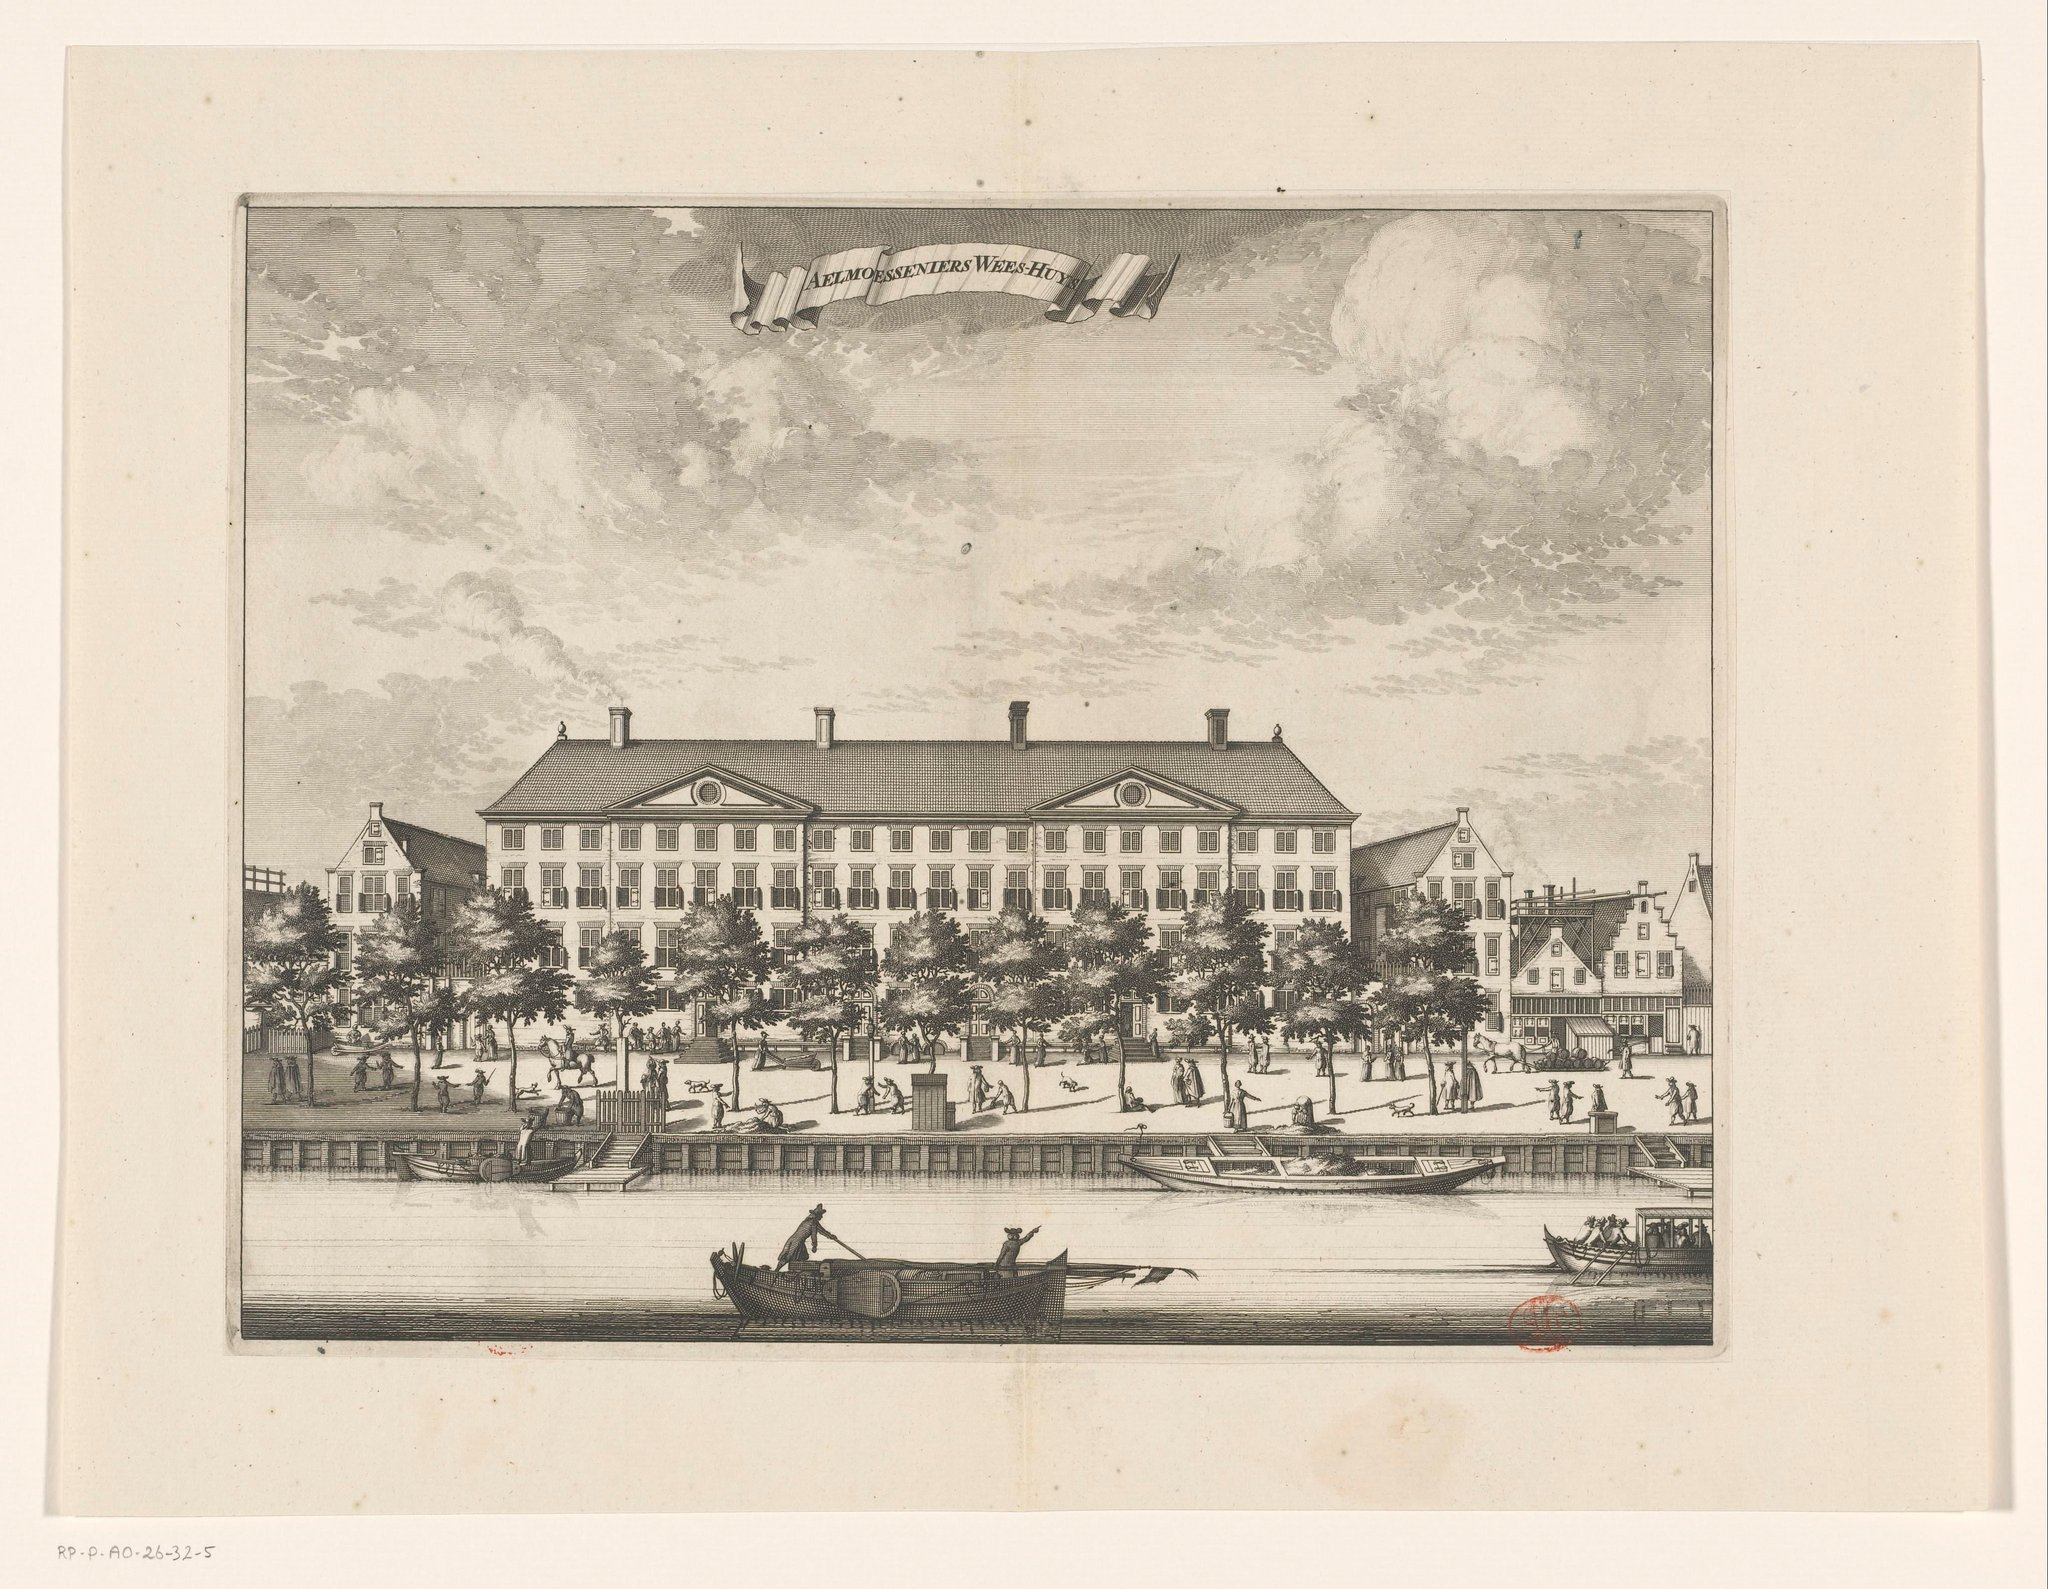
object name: book illustration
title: Gezicht op het Aalmoezeniersweeshuis te Amsterdam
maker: Anonymous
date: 1693-1694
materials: paper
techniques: engraving, etching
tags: public welfare, poorhouse, orphanage, canals, waters (in city) (+ city(-scape) with figures, staffage), street (+ city(-scape) with figures, staffage)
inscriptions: collector's mark: Lugt 195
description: Huidige staat van prent ook gebruikt in: Commelin, Caspar. Beschryvinge van Amsterdam, desselfs eerste oorspronk uyt den Huyse (…). 2 delen. Amsterdam: Abraham Wolfgang, Gillis Janssonius van Waesberge, Johannes Janssonius van Waesberge II, weduwe Dirk Boom I, Hendrick Boom en Rembertus Goethals, 1693. En in: Commelin, Caspar. Beschryvinge van Amsterdam, zynde een naukeurige verhandelinge van desselfs eerste oorspronk uyt (…). 2 delen. Amsterdam: weduwe Aart Dircksz Oossaan, 1694. Latere staat ook gebruikt in: Commelin, Caspar. Beschryvinge van Amsterdam, zynde een naukeurige verhandelinge van desselfs eerste oorspronk uyt (…). 2 delen. 2e druk. Amsterdam: Andries van Damme, Johannes Ratelband, weduwe A. van Aaltwyk en Hermanus Uytwerf, 1726. Zie RP-P-AO-26-32-1, RP-P-AO-26-32-2, RP-P-AO-26-32-3 en RP-P-AO-26-32-4 voor de bijhorende beschrijving.